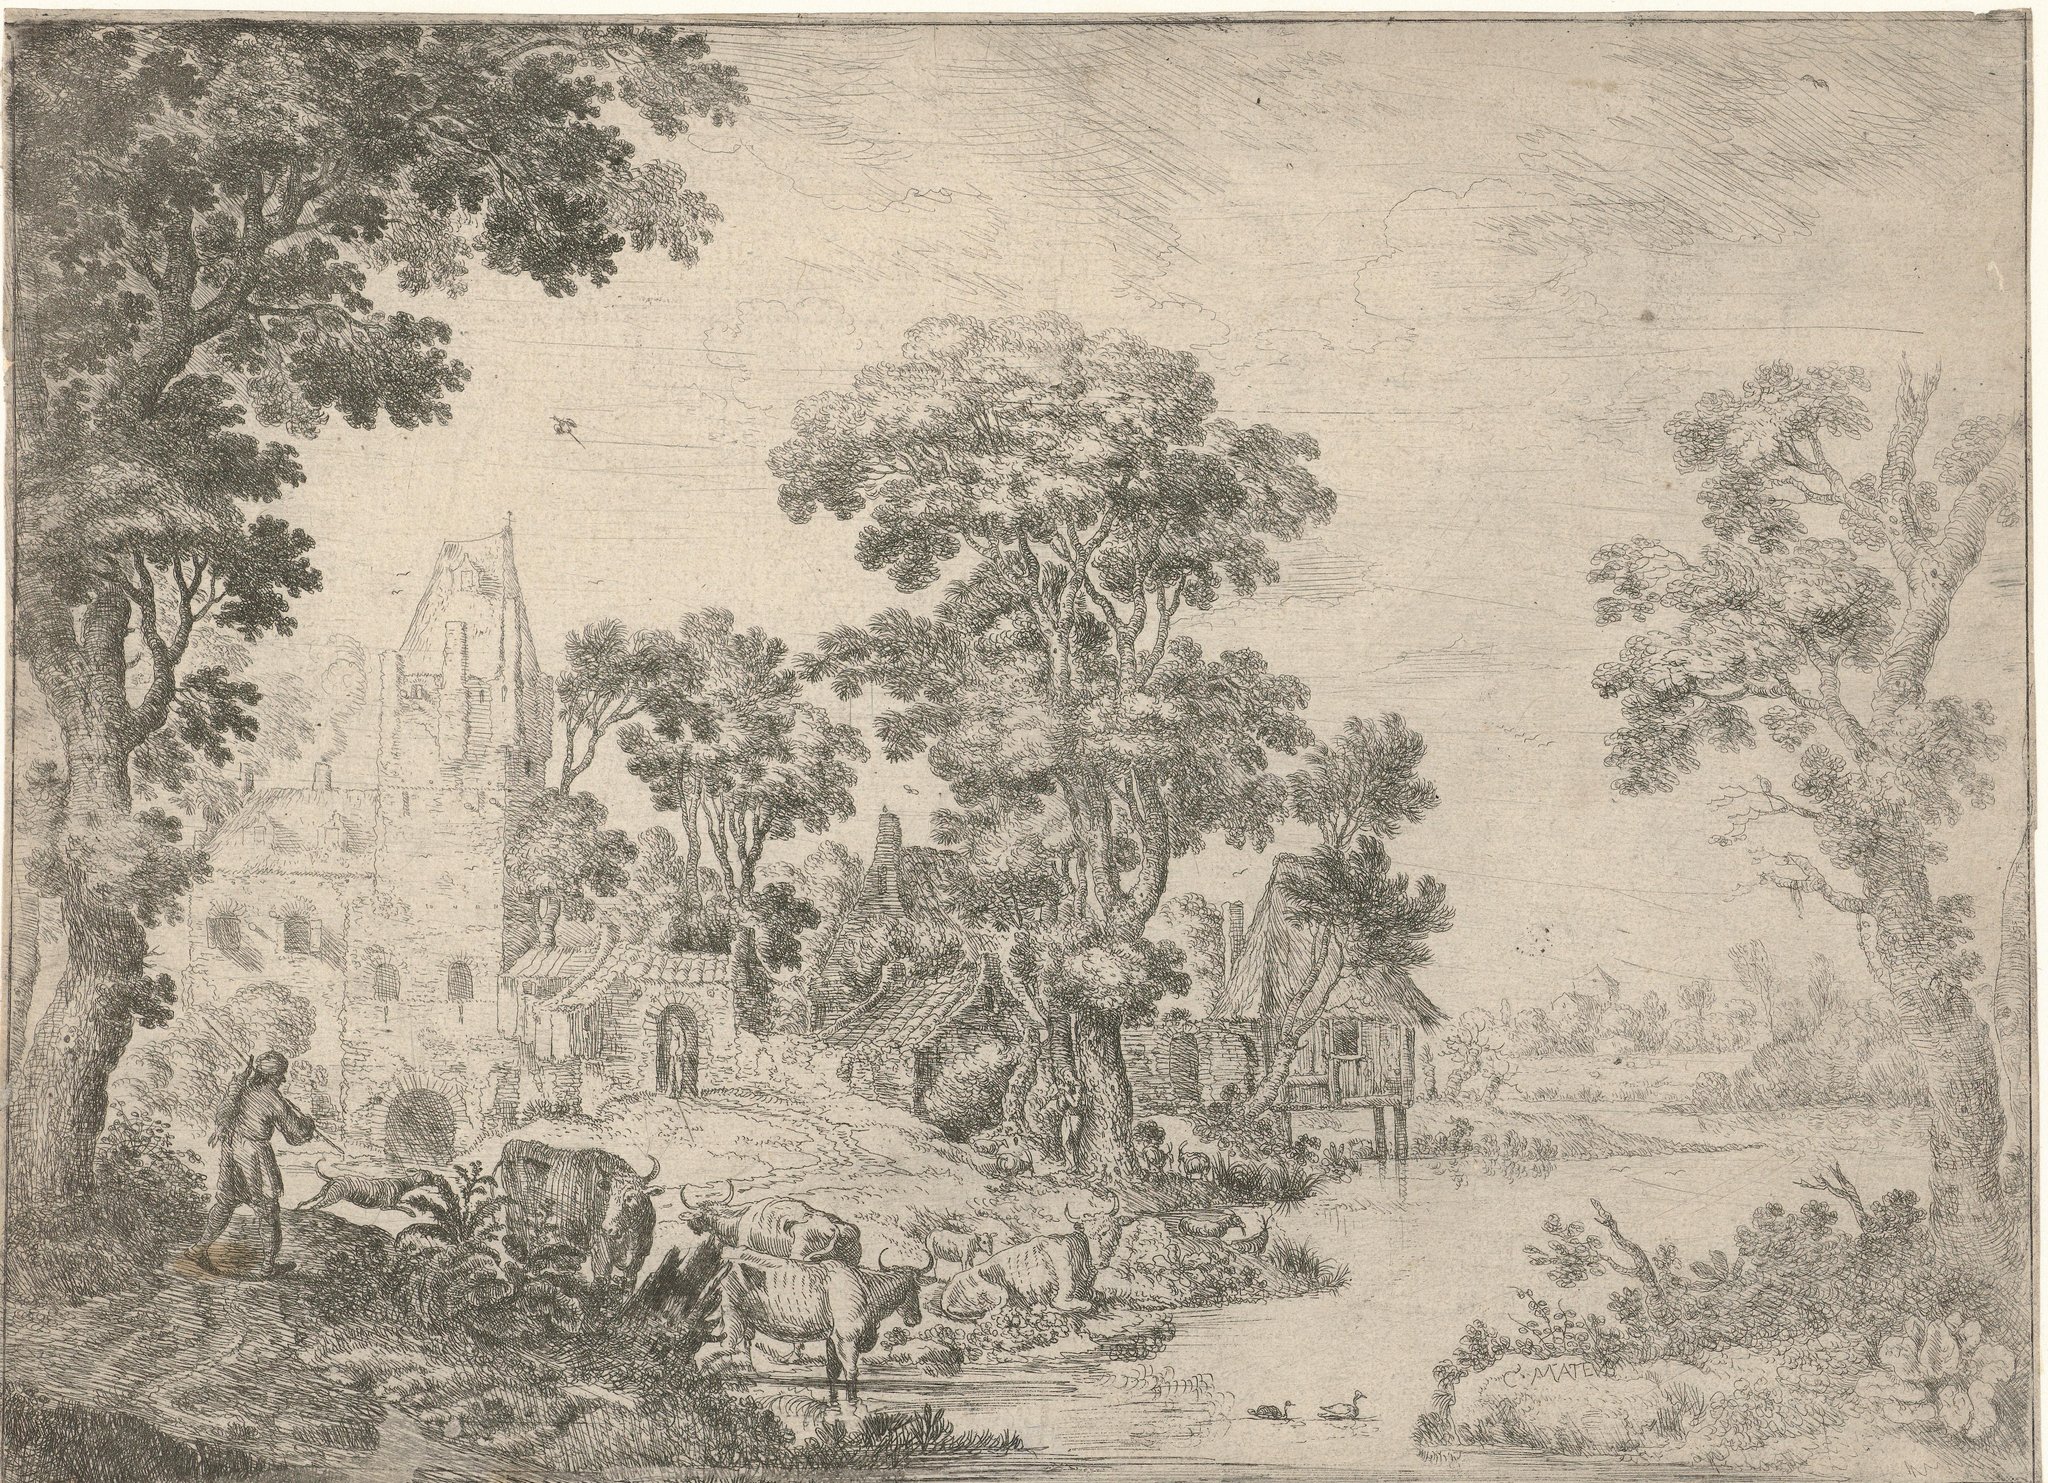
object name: print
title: Terugkomst van de jager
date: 1637-1656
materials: paper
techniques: etching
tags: cow, spoils of the hunt, game, venison, landscape with tower or castle, return from the hunt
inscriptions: collector's mark: Lugt 2610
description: Een jager loopt met zijn vangst aan een stok op een dorp en een slot aan het water toe. Zijn jachthond gaat voor hem uit en aan het water staan koeien.